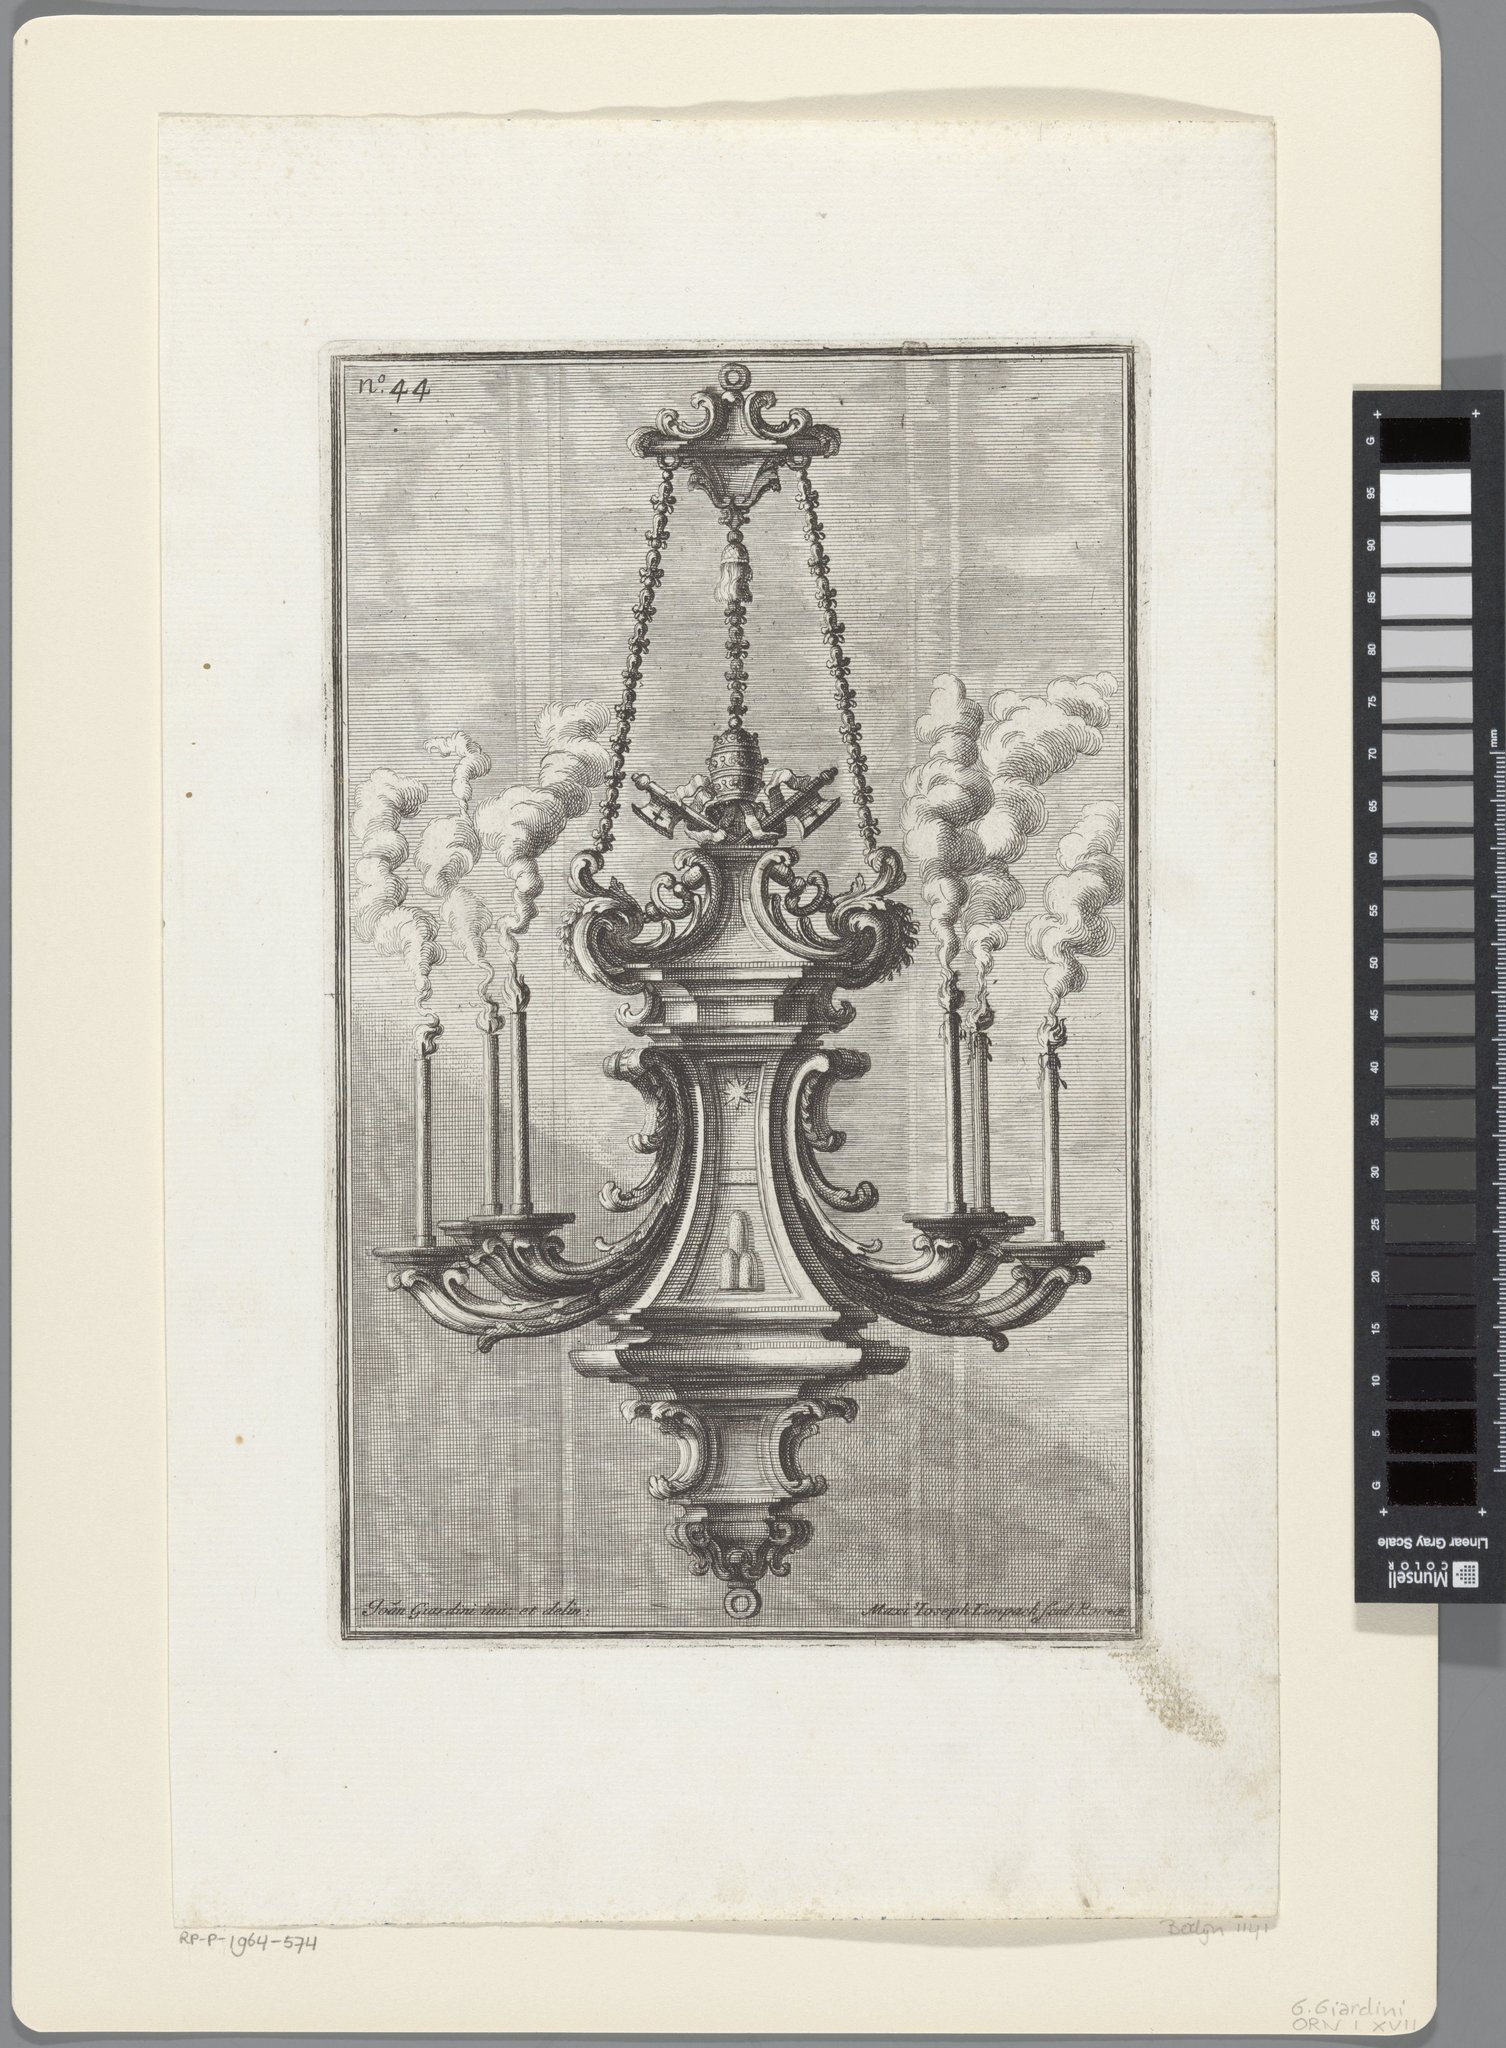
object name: print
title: Diverse kerkelijke voorwerpen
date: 1714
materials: paper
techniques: etching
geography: rome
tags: clergyman, clemens xi, chandelier, candelabrum, candle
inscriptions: collector's mark: Lugt 2228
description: Prent maakt deel uit van een reeks van 100 ornamentprenten naar ontwerp van Giovanni Giardini.